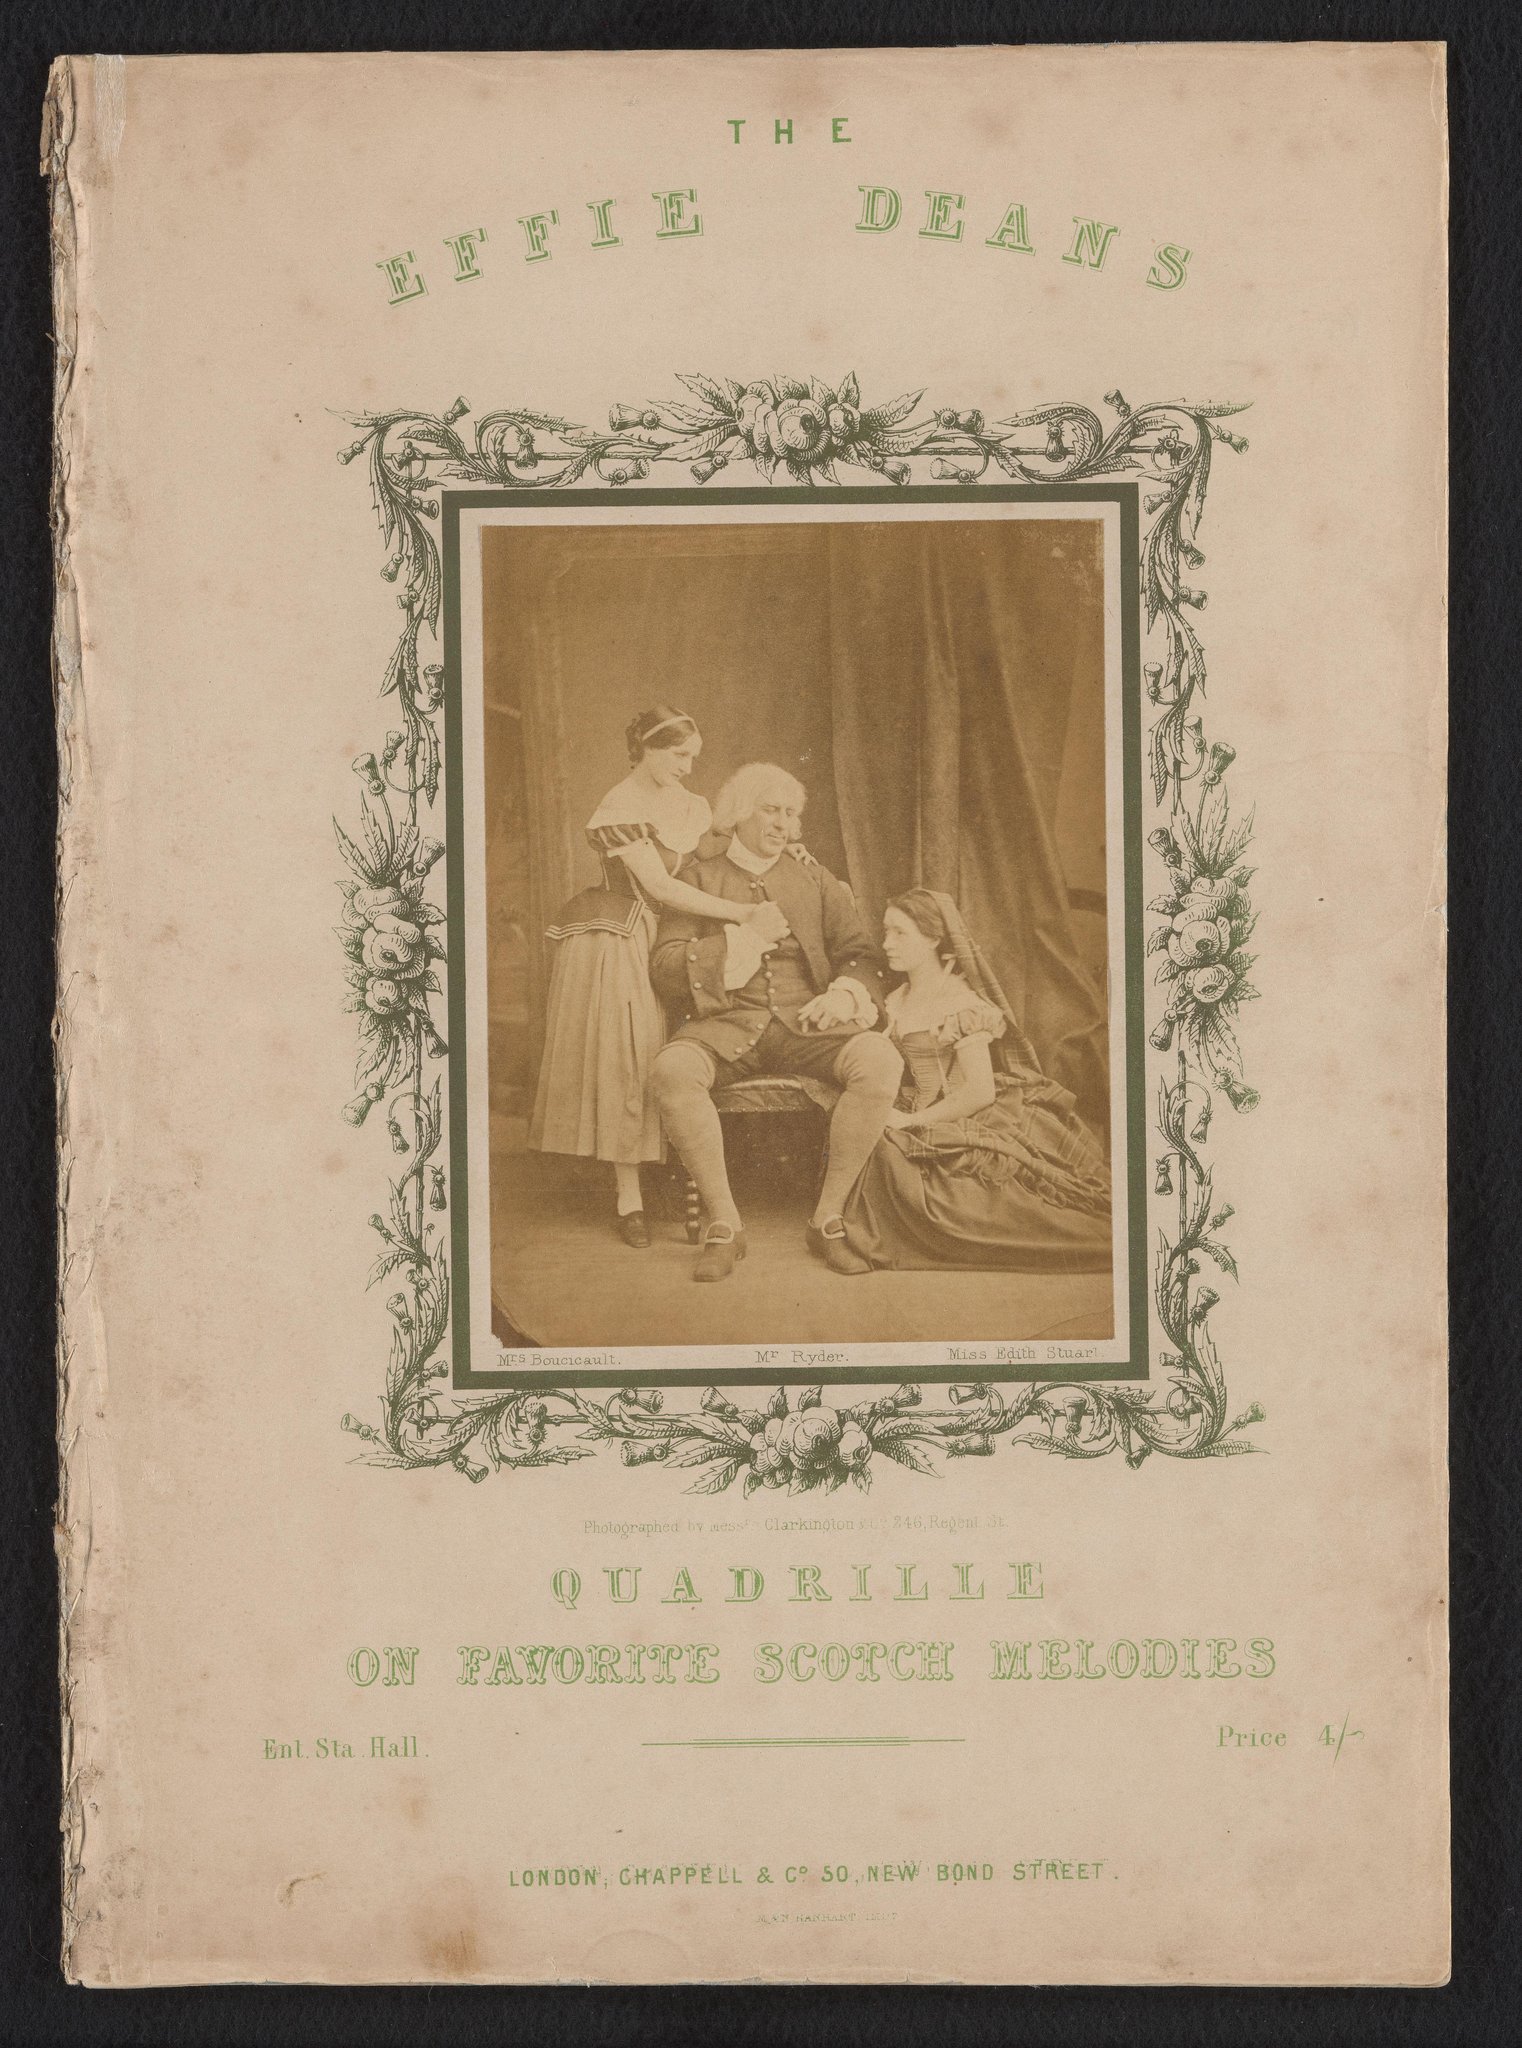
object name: photograph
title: The Effie Deans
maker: edouard frewin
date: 1865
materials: paper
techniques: albumen print, printing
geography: london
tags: historical persons, portrait of actor, actress, clothes, costume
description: Boek met bladmuziek, "The Effie Deans" van Edouard Frewin, met op het voorblad een foto met een portret van Agnes Kelly Boucicault-Robertson, John Ryder en Edith Stuart in kostuum voor het theaterstuk "The Trial of Effie Deans" in het Westminster Theatre, Londen.